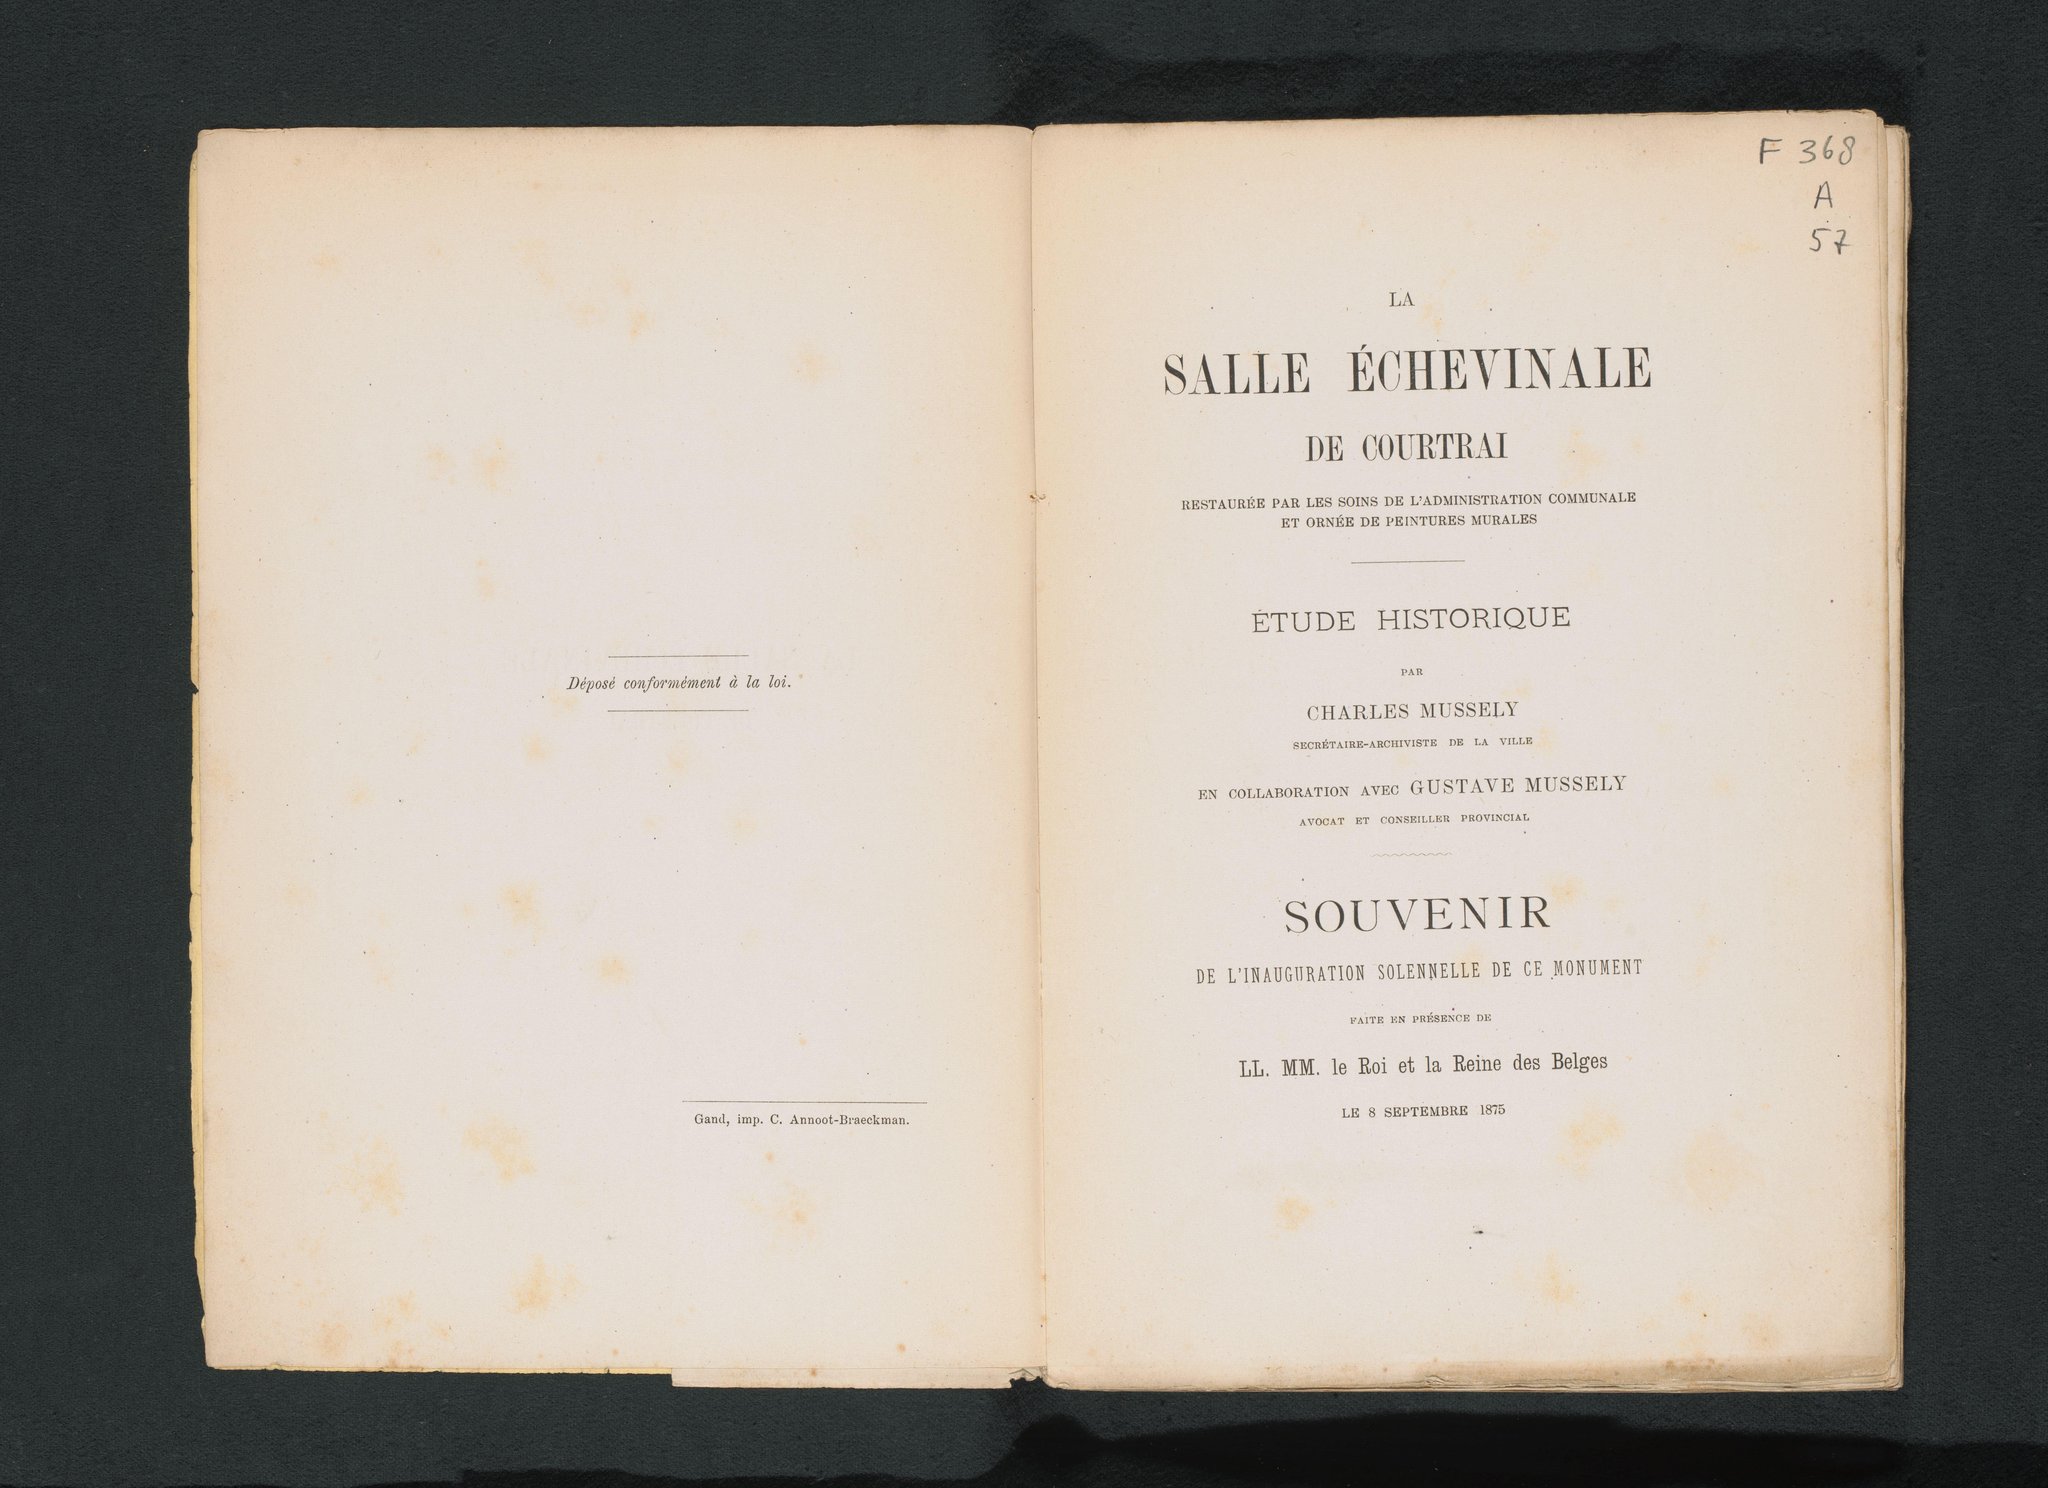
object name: book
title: La Salle Échevinale de Courtrai : restaurée par les soins de l'administration communale et ornée de peintures murales / études historique par Charles Mussely, en collaboration avec Gustave Mussely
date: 1876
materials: paper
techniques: printing, woodburytype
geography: ghent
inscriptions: annotation: ‘2.50 vijt 12 aout 85/ 58 Ro[.]ten/ 3.08’, date: ‘MAR/ 1985’